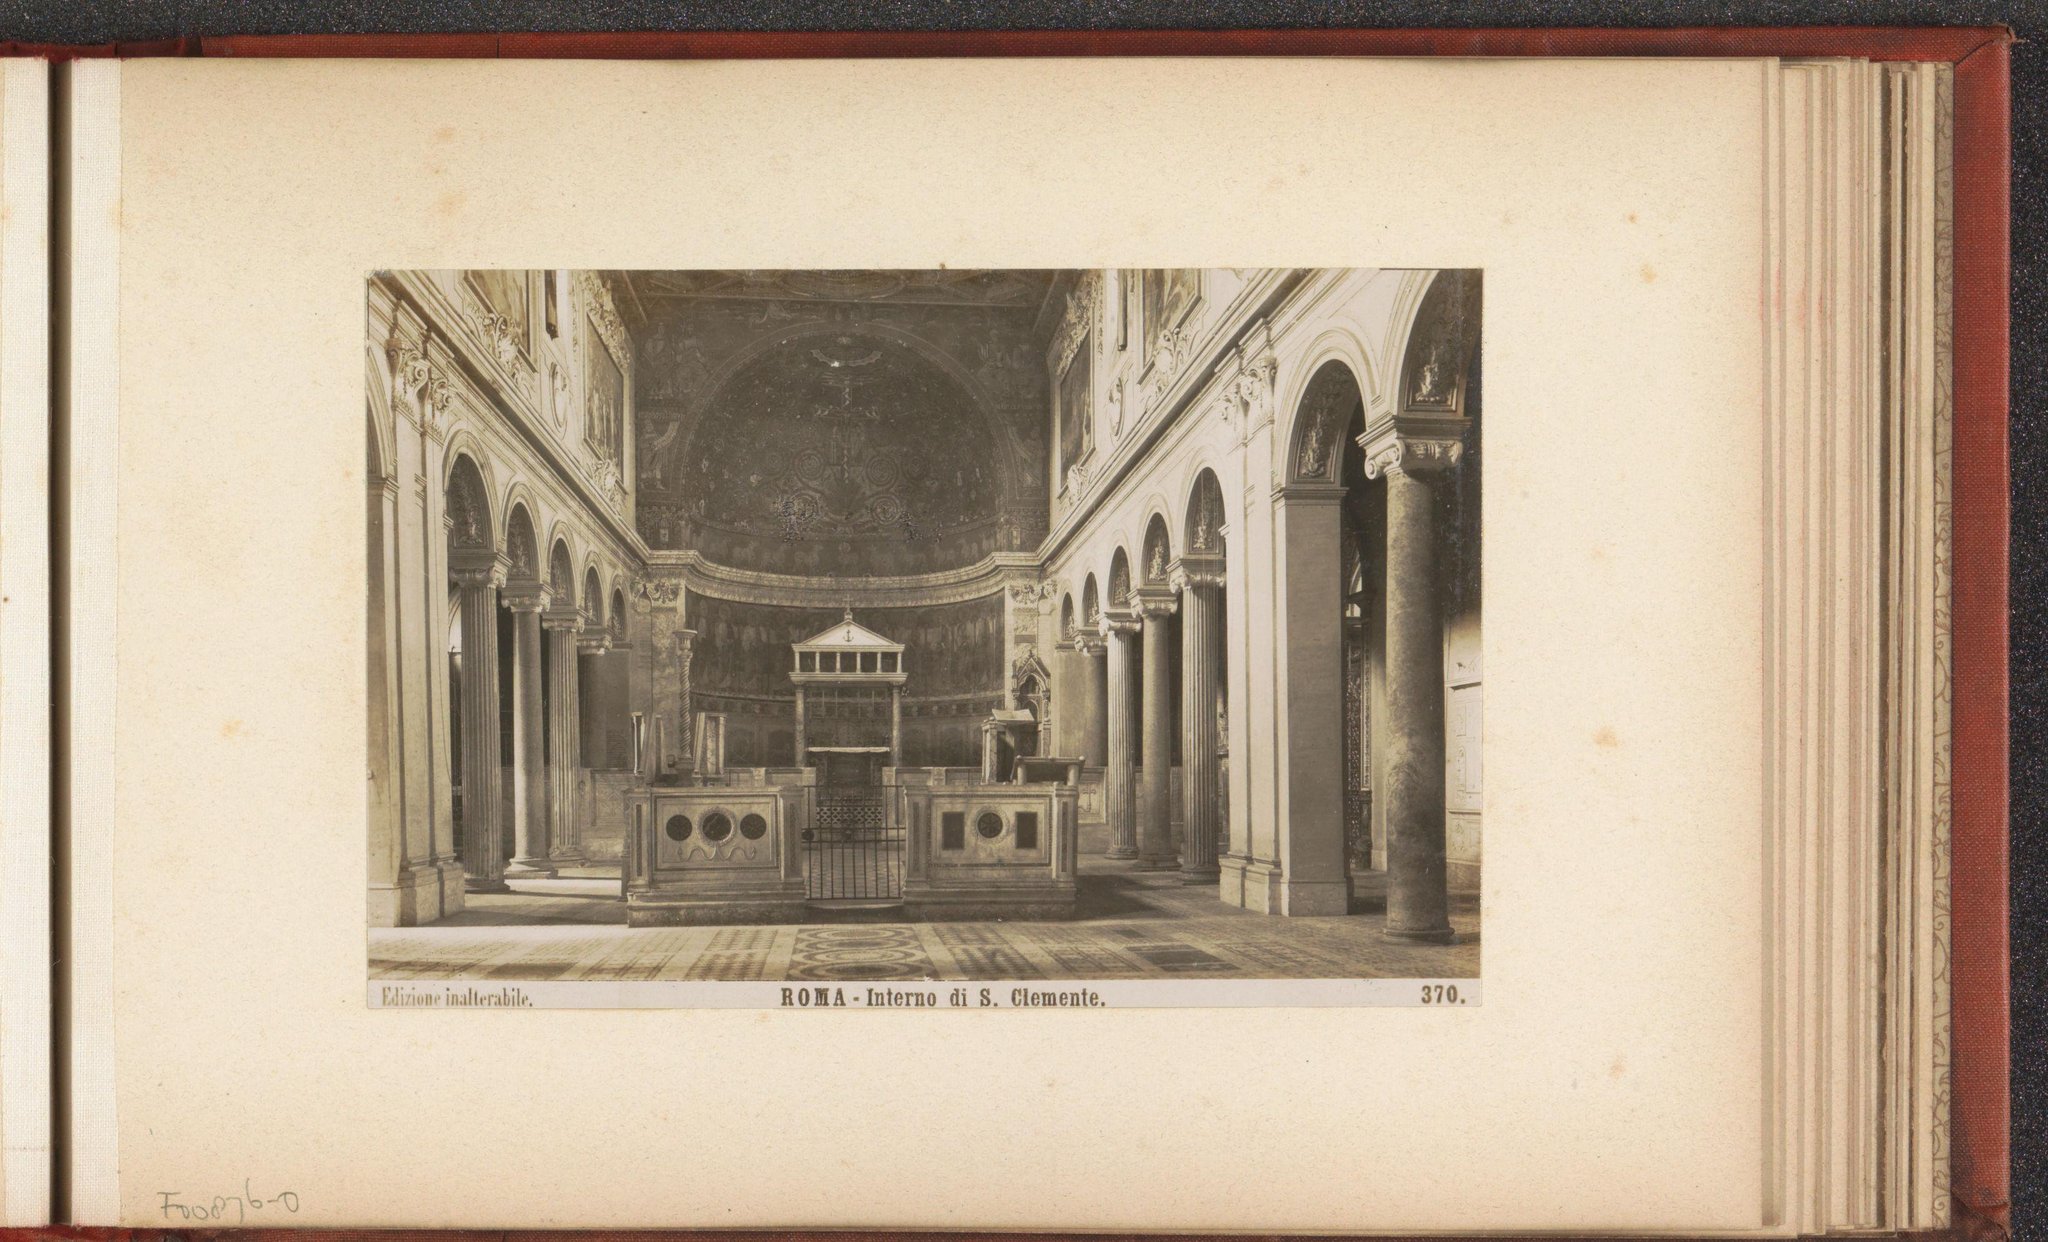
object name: photograph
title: ROMA - Interno di S. Clemente.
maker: Anonymous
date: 1860-1890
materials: cardboard, photographic support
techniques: gelatin silver print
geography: rome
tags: interior of church, altar, prospect of city, town panorama, silhouette of city, rome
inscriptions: number: ‘370’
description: Onderdeel van Fotoalbum met opnames van kerken, beelden en antieke gebouwen in Rome.